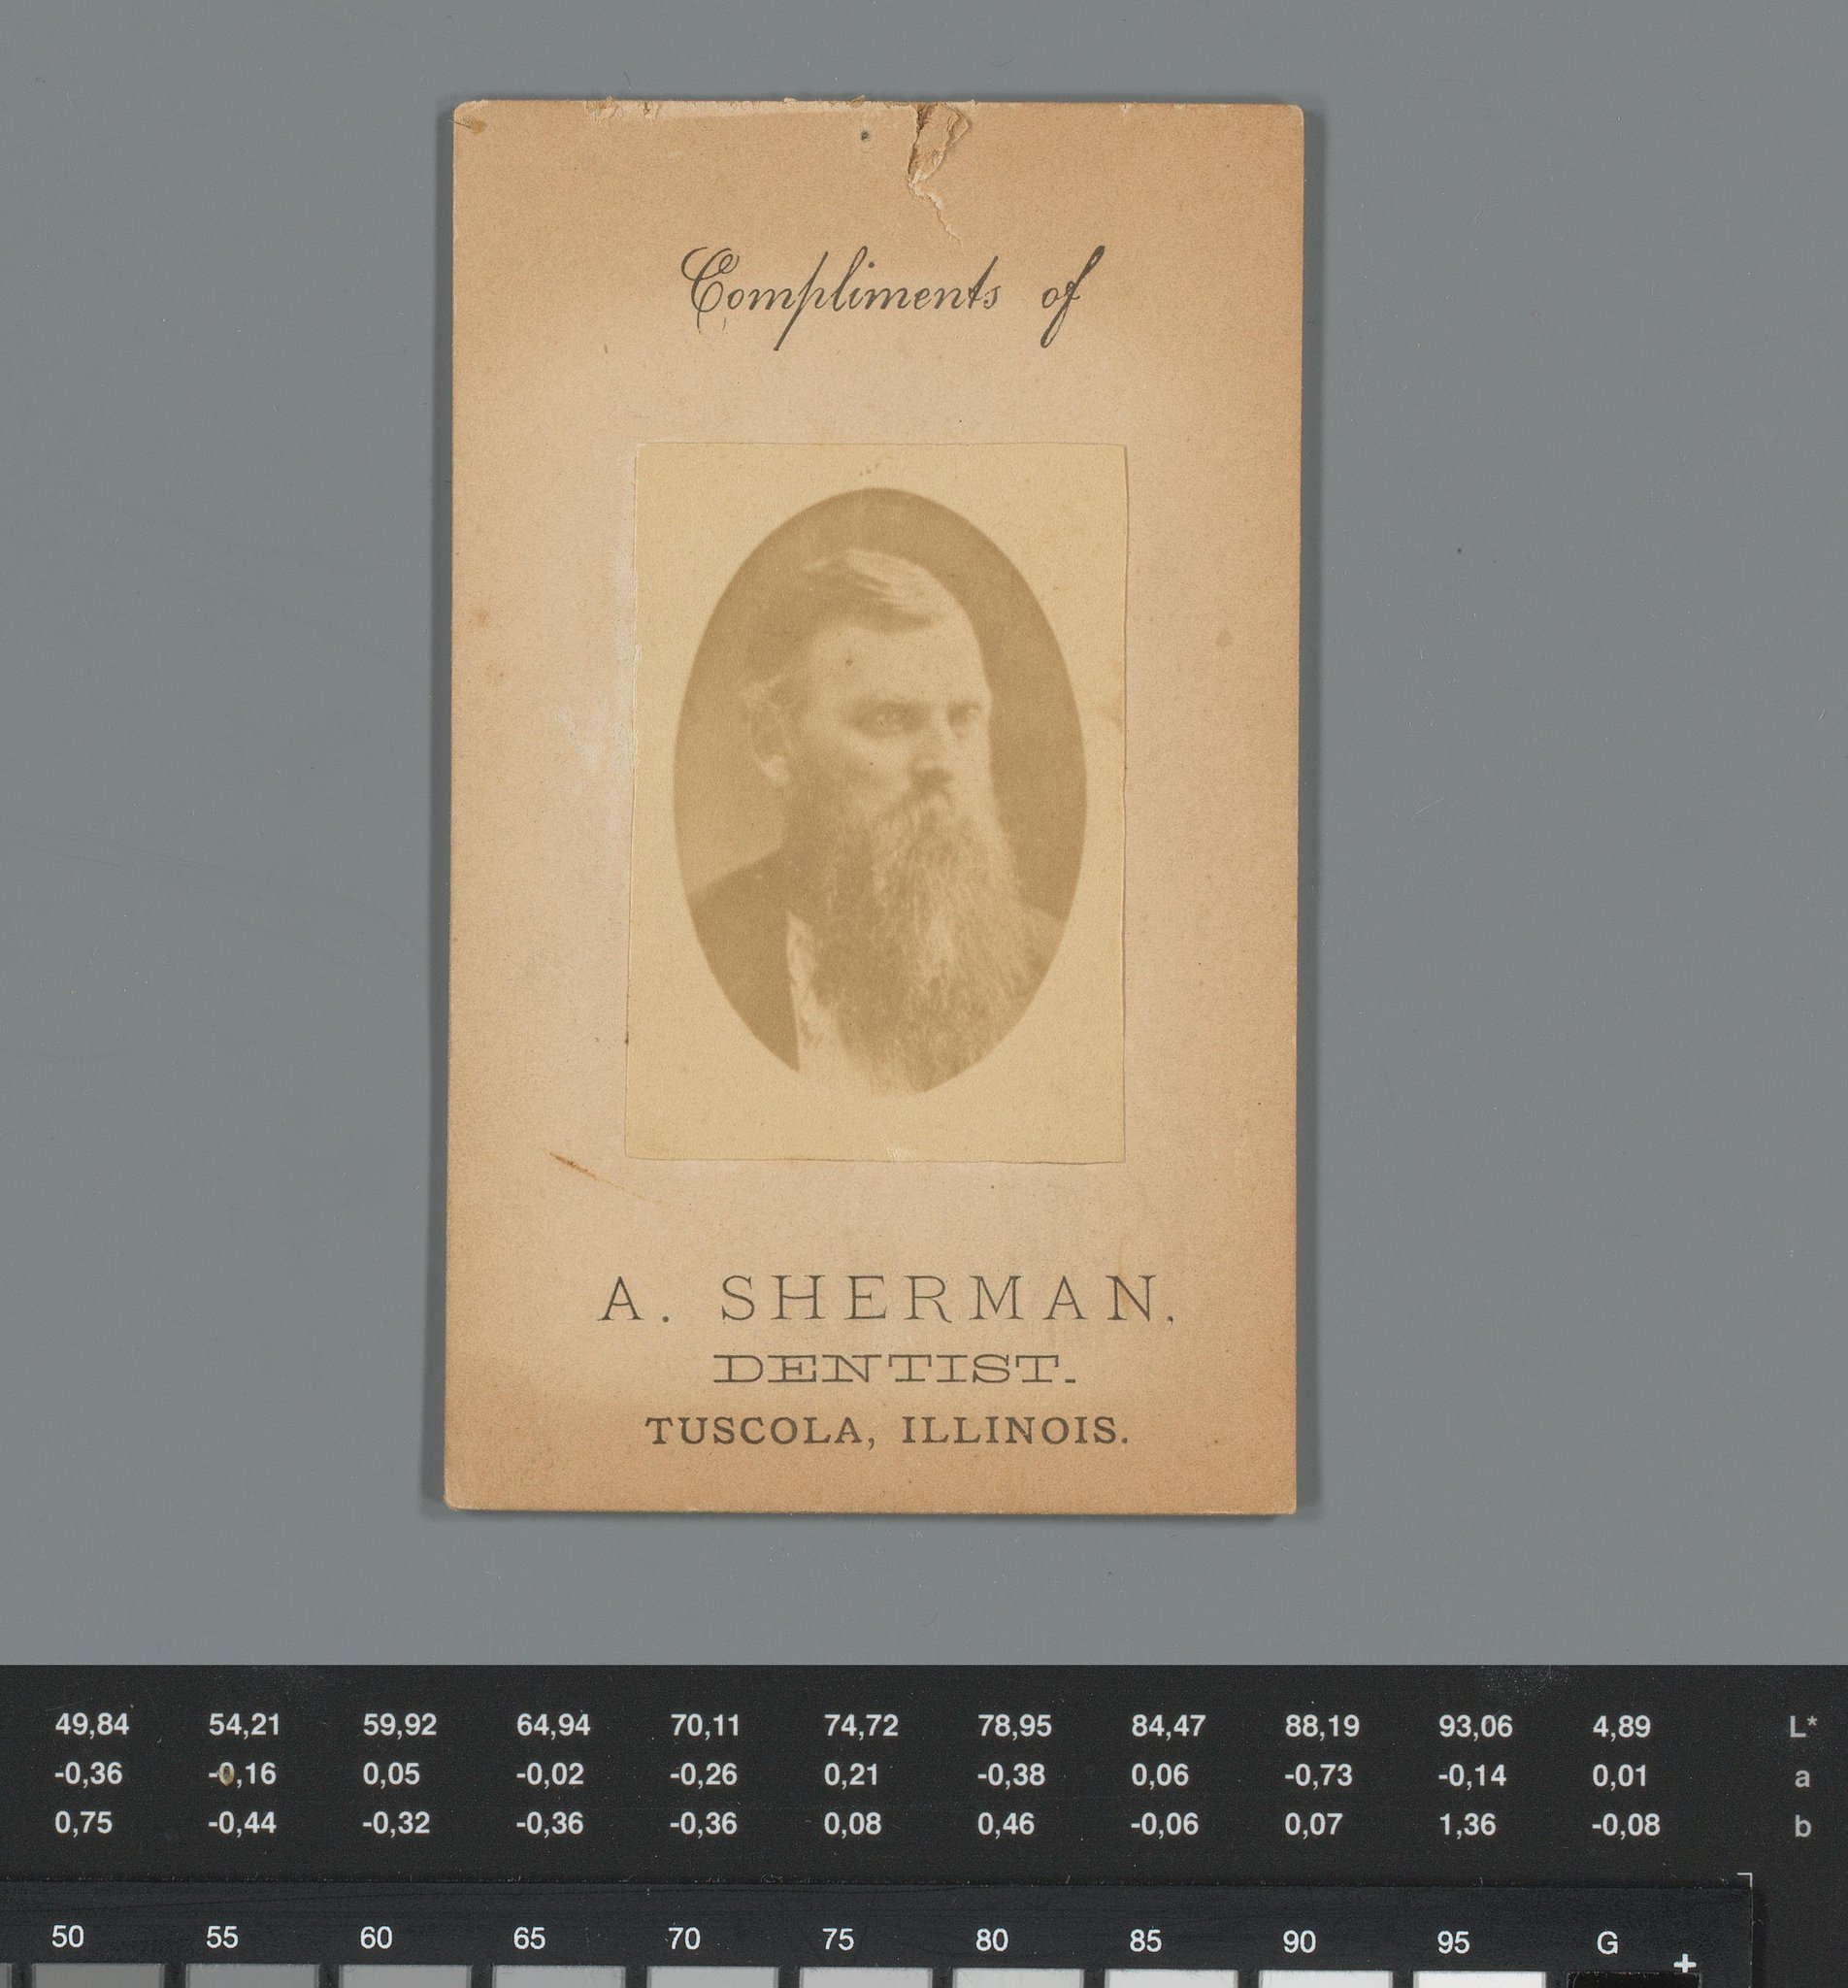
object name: photograph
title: Portret van A. Sherman als reclame voor zijn tandartspraktijk in Tuscola, Illinois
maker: Anonymous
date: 1850-1915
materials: cardboard, photographic support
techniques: albumen print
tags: advertising, historical persons